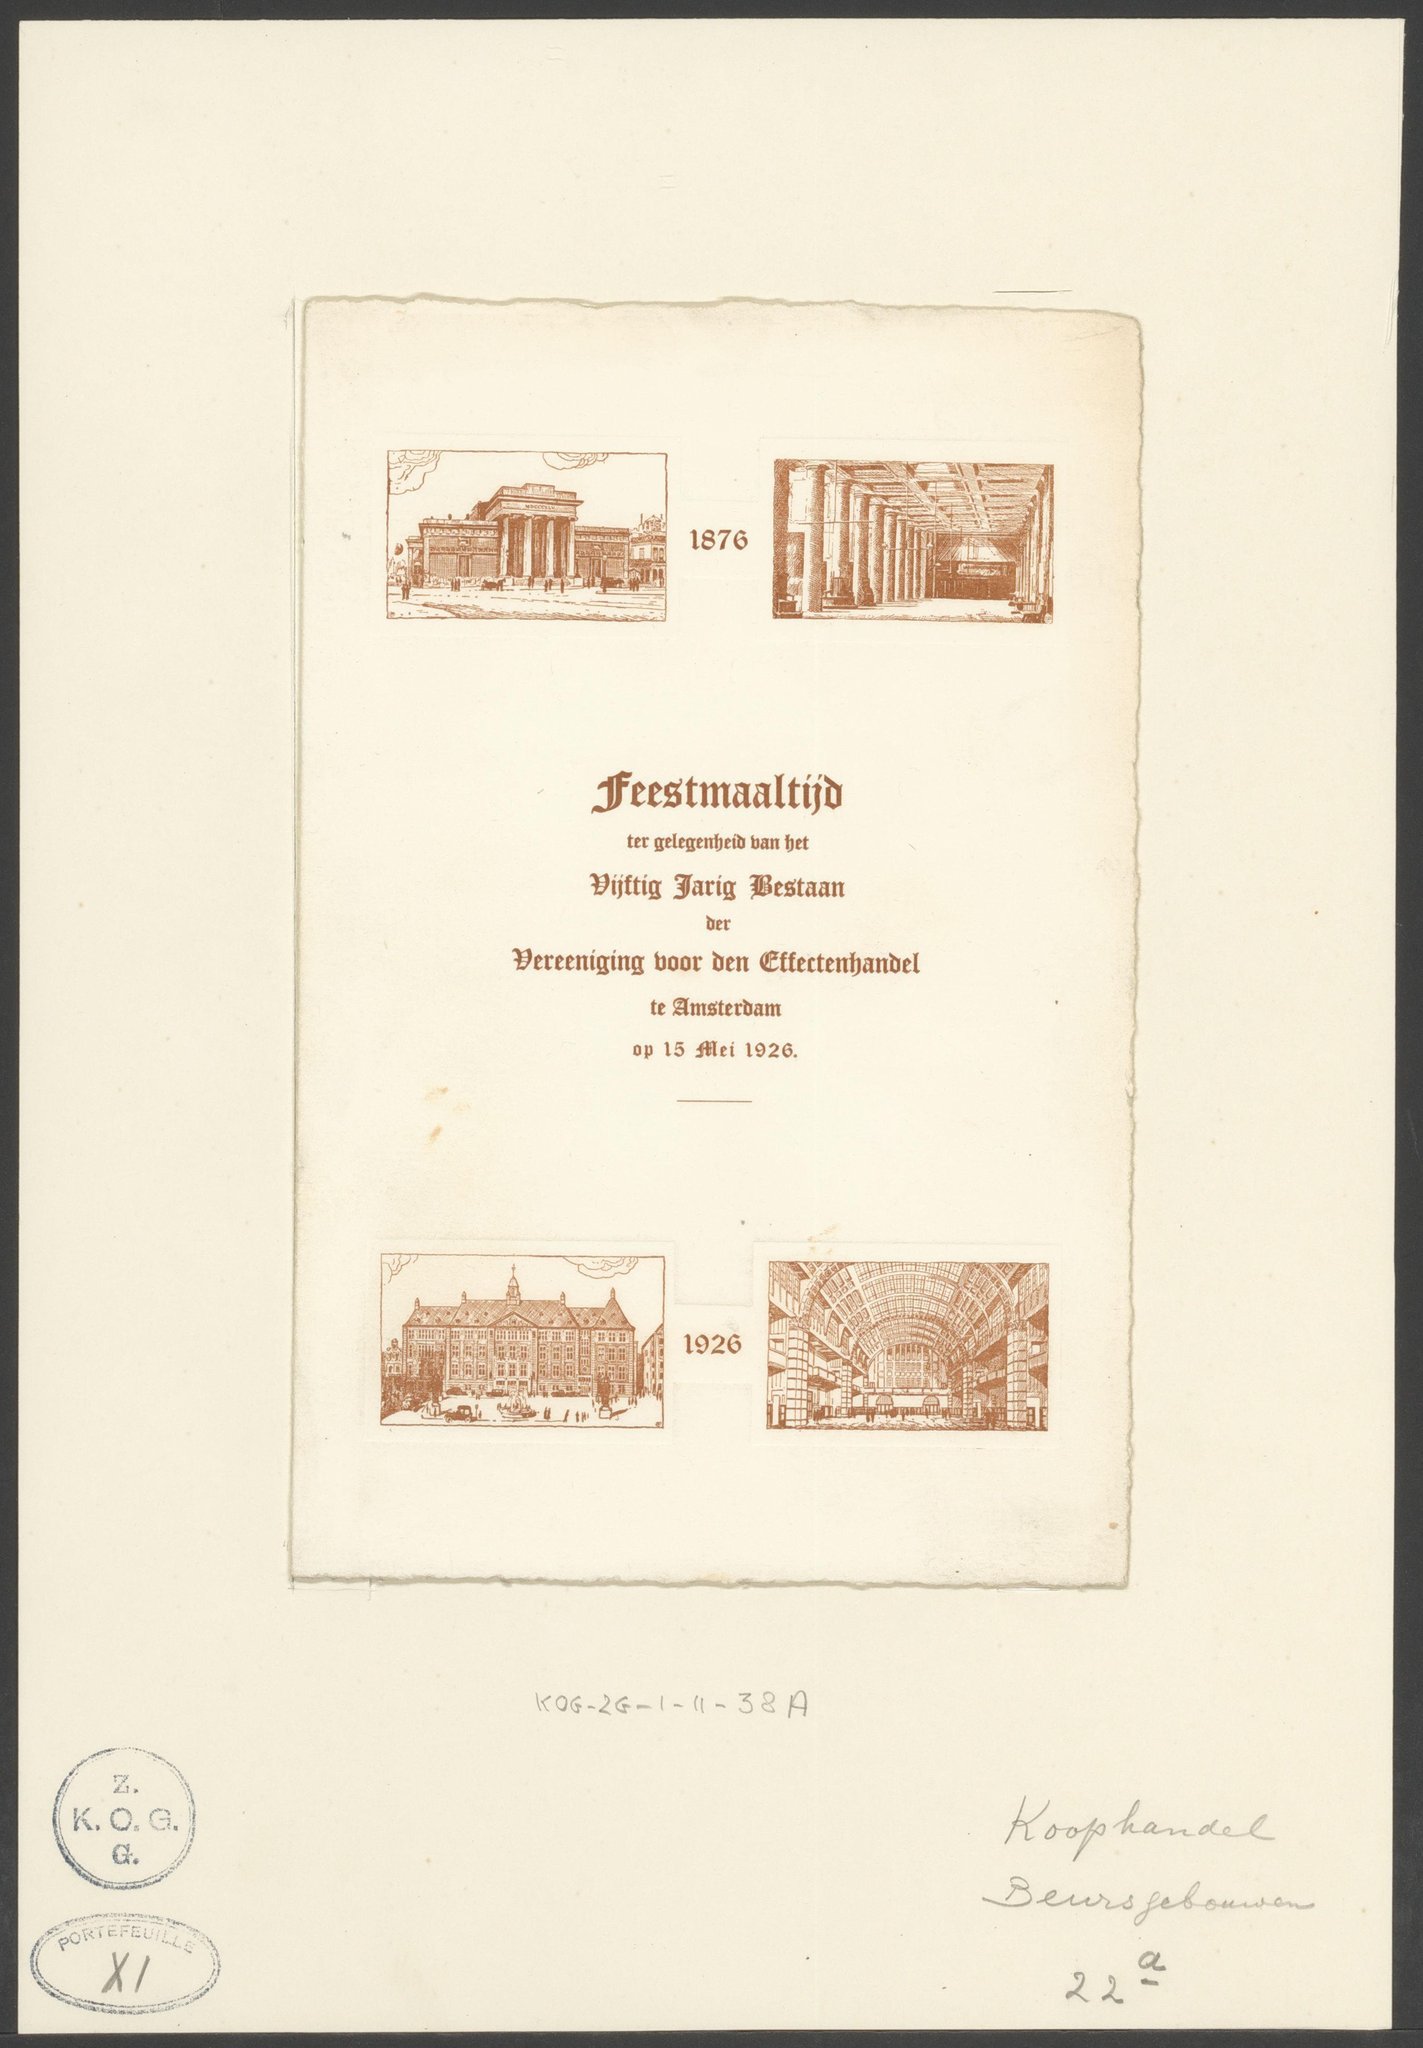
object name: print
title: Menukaart met het interieur en exterieur van twee beursgebouwen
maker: Anonymous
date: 1926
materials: cardboard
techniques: blind stamped, letterpress printing, printing block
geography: amsterdam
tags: stock exchange, stock-market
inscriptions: collector's mark: Lugt 1641, stamp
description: Menukaart voor het diner ter gelegenheid van het vijftig jarig bestaan van de Vereeniging voor den Effectenhandel (1876-1926). De gevouwen menukaart is op drie kanten bedrukt. Op het recto de titel en het interieur en exterieur van twee beursgebouwen. Op de twee pagina een lijst met namen van de sprekers van de avond. Op de derde pagina de menukaart met dertien gangen en bijpassende wijnen. Onderwerpsrubrieken binnen de Atlas Zeden en Gewoonten: Handel, nijverheid en verkeer, Koophandel, Beursgebouwen.